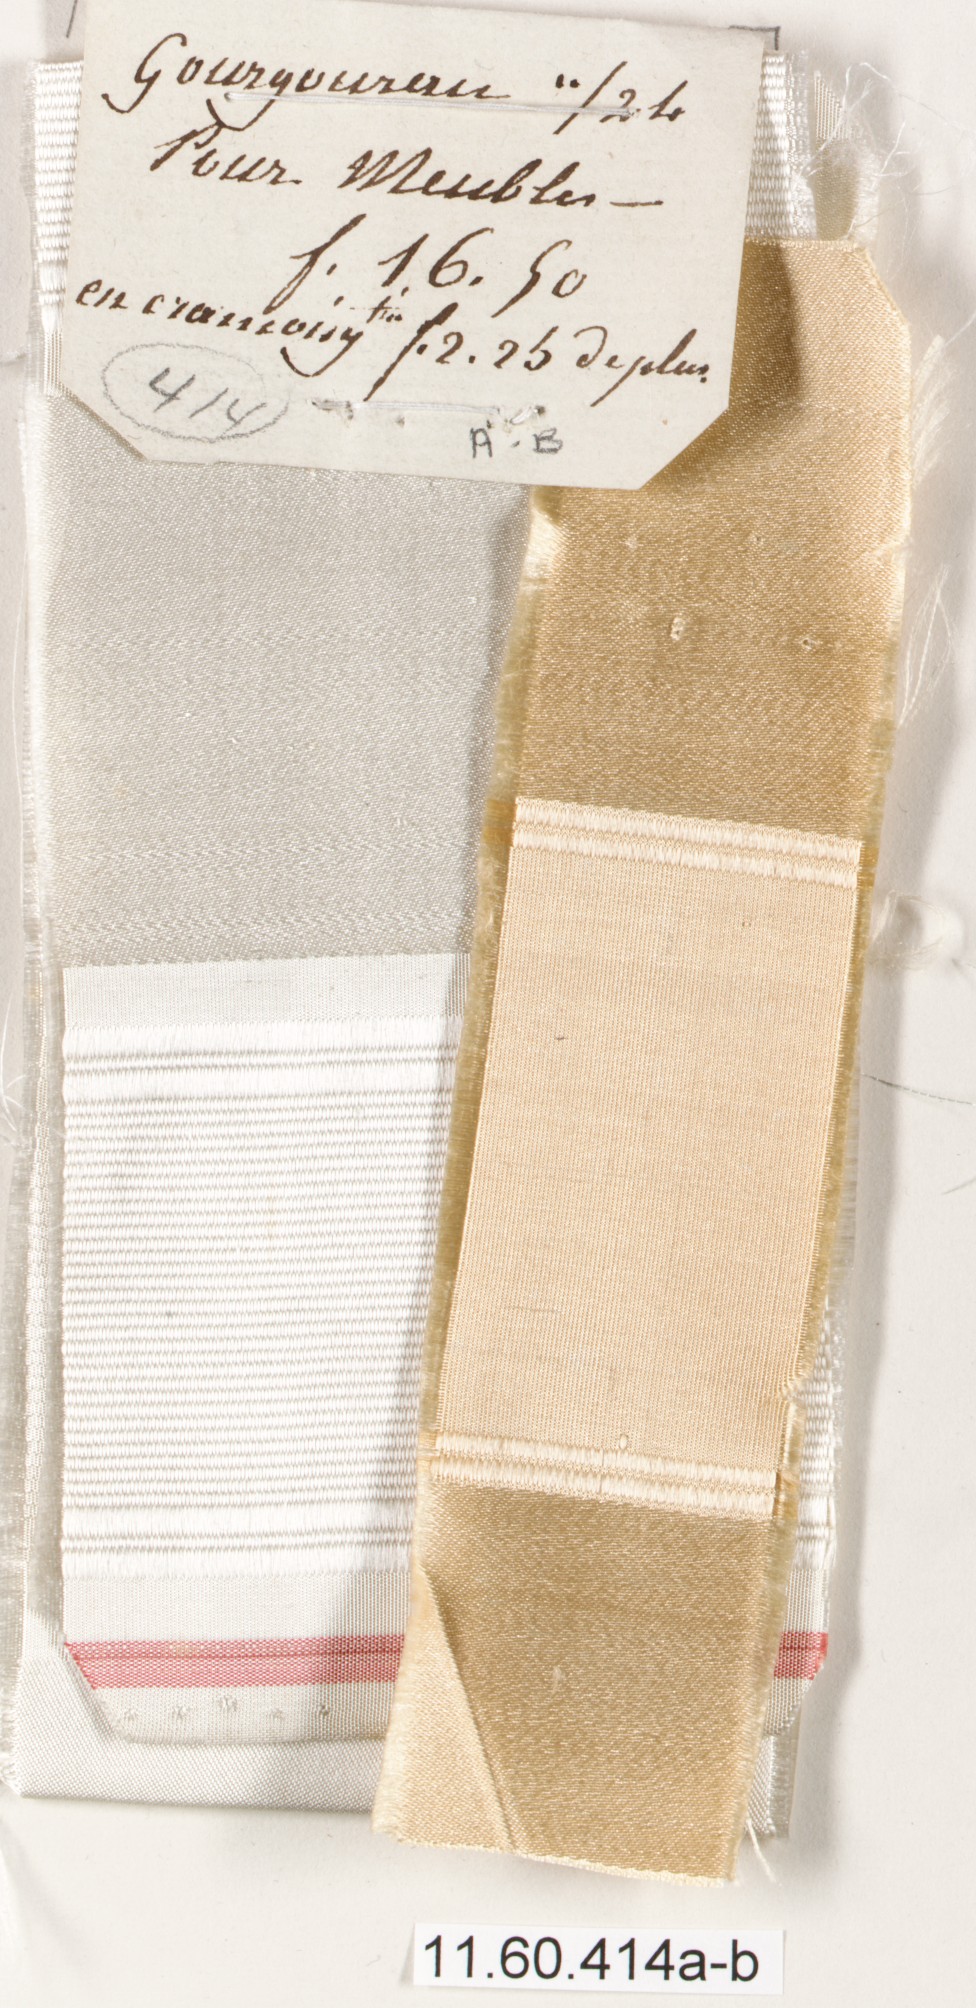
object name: fragment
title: Fragments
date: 1801-1900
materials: silk